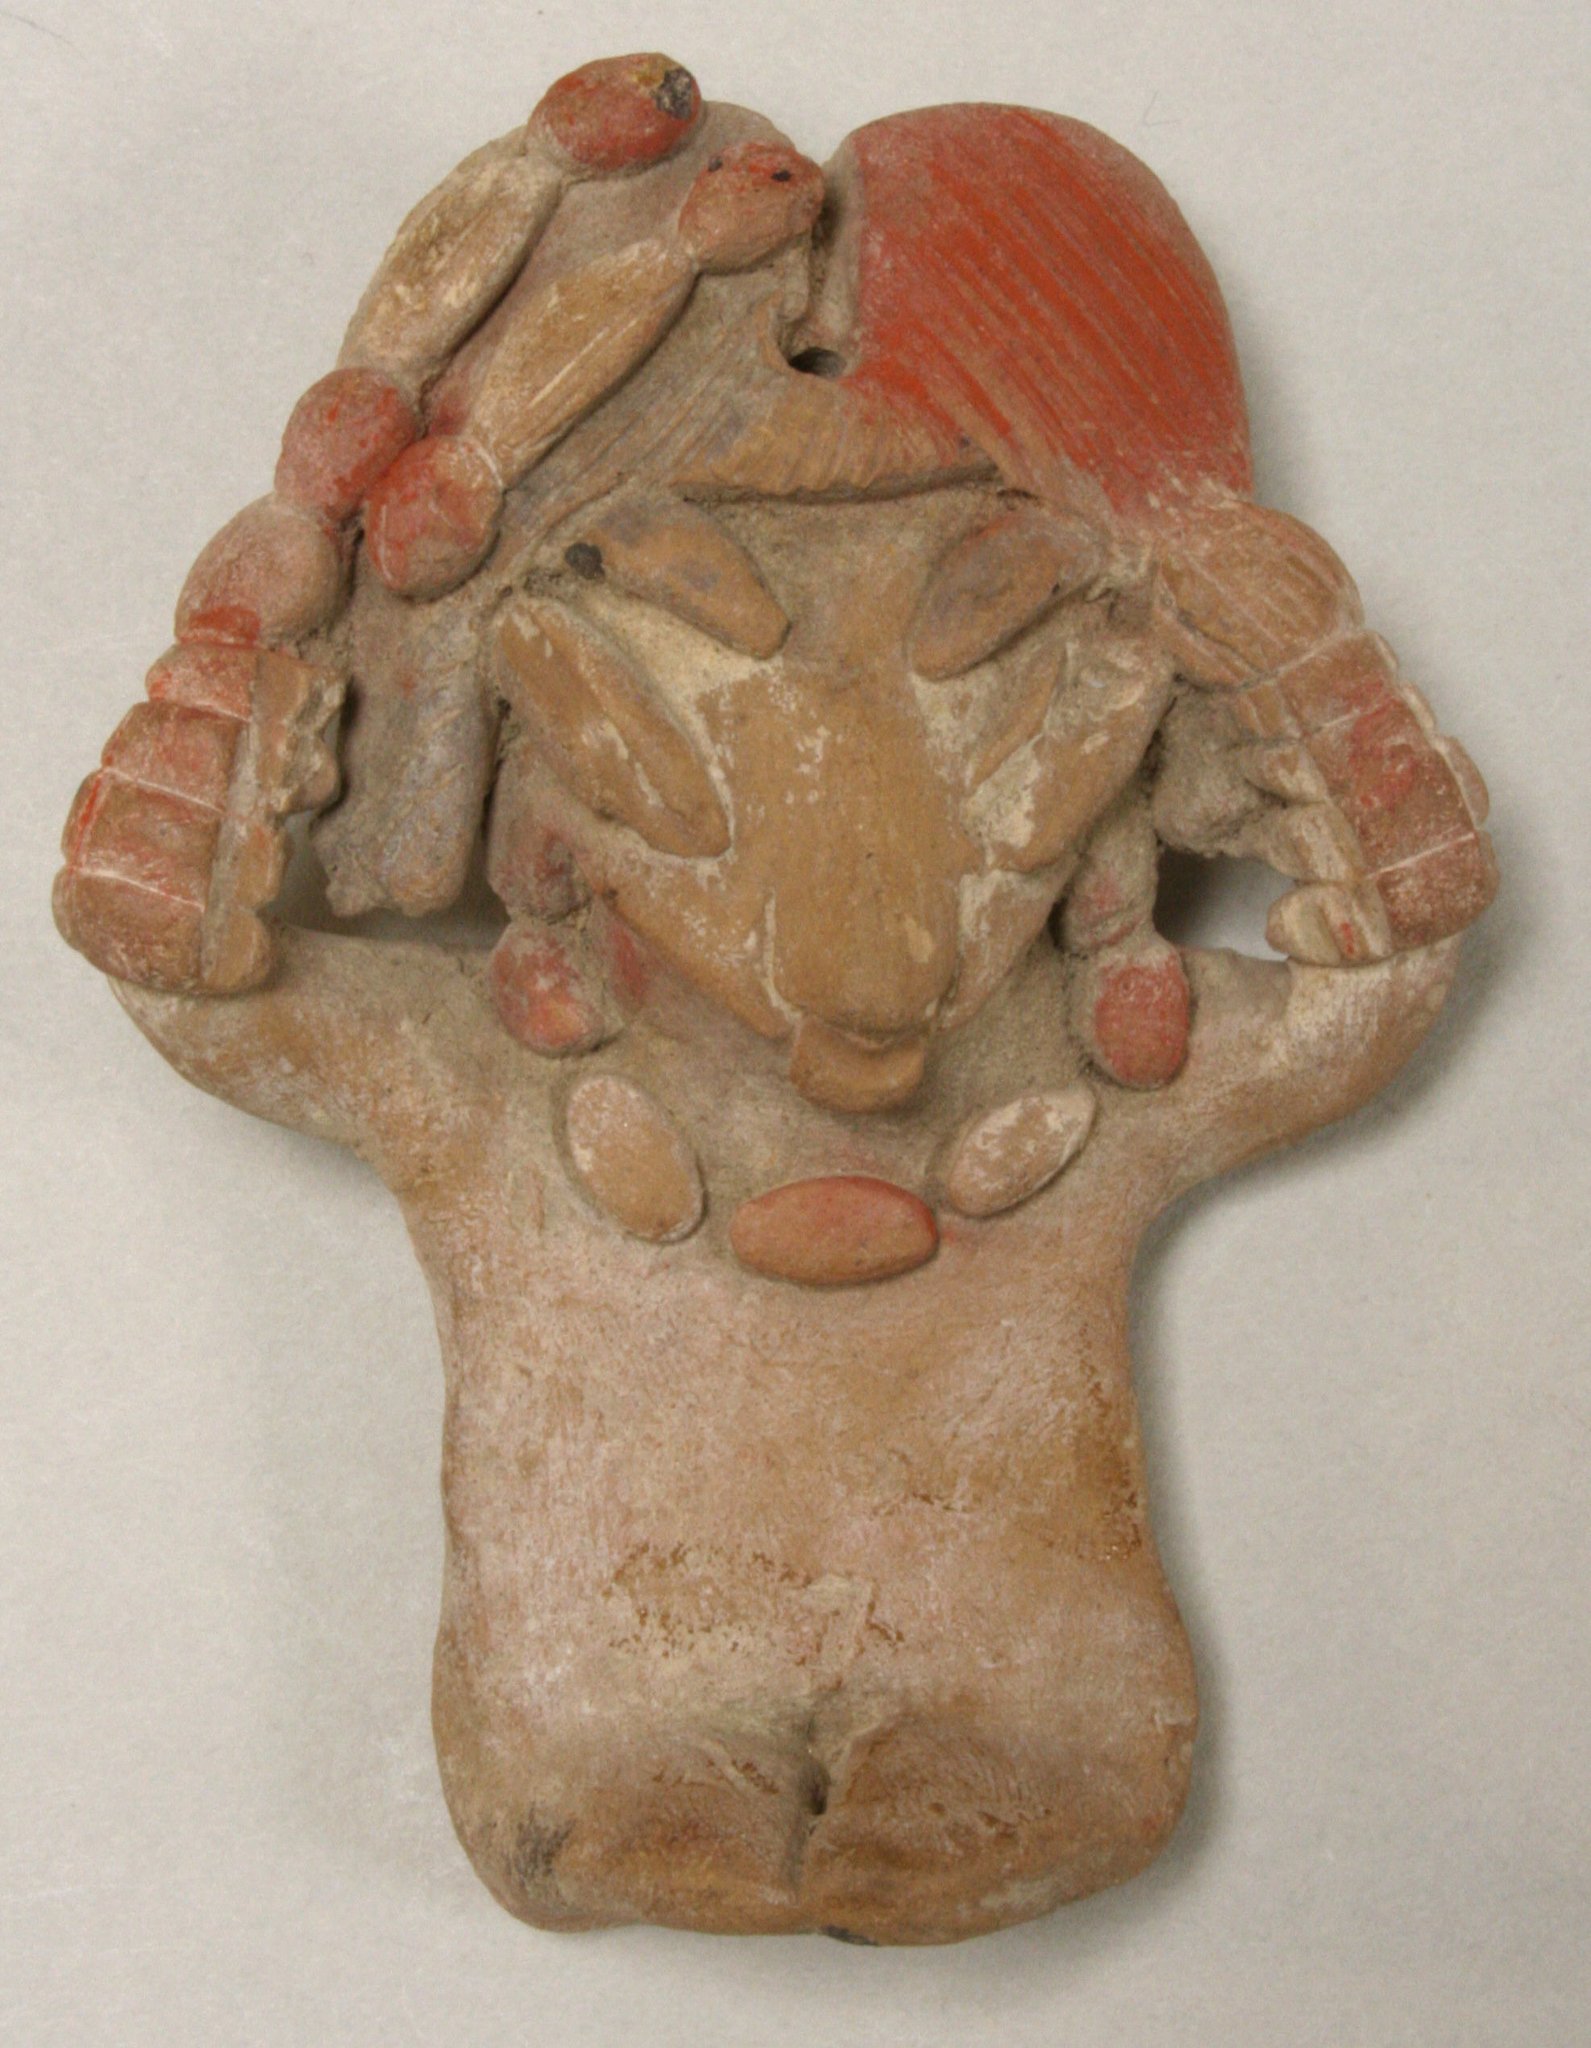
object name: figure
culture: chupicuaro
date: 300 BCE-400 CE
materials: ceramic, pigment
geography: mexico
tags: human figures